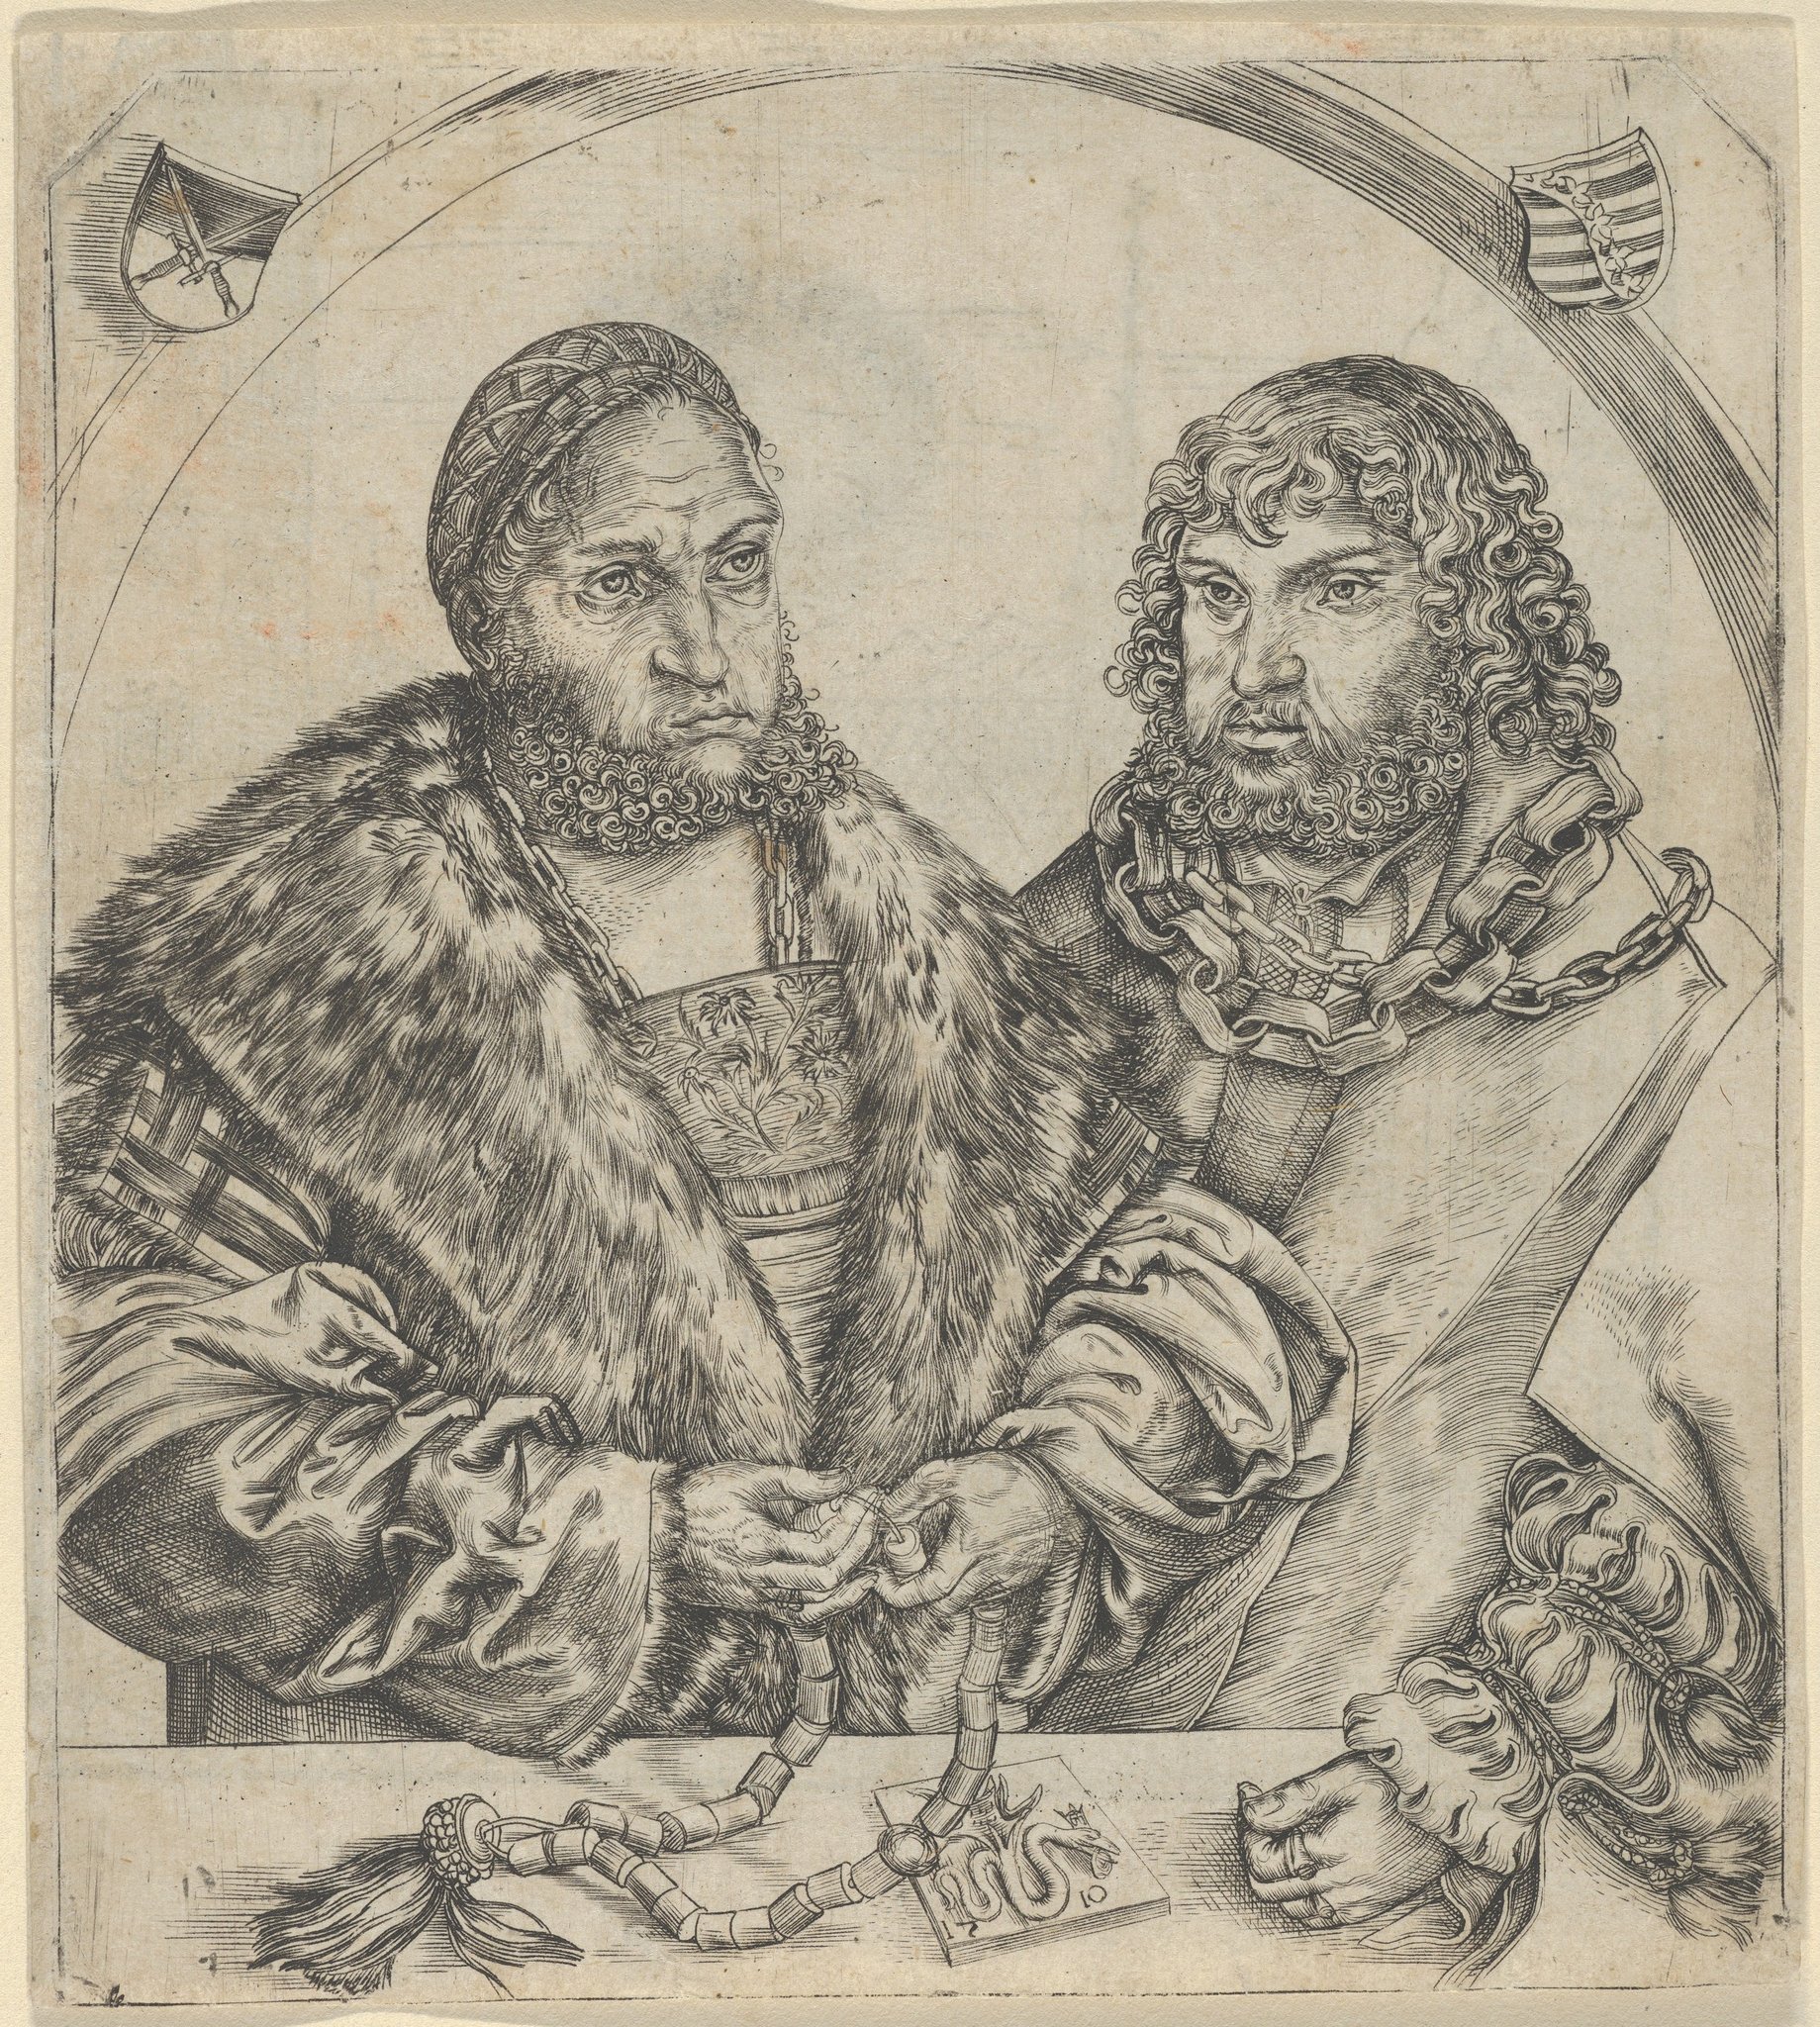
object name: print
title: Frederick the Wise and John the Constant of Saxony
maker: lucas cranach the elder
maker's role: artist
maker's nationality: german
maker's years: 1472-1553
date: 1509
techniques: engraving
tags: men,portraits